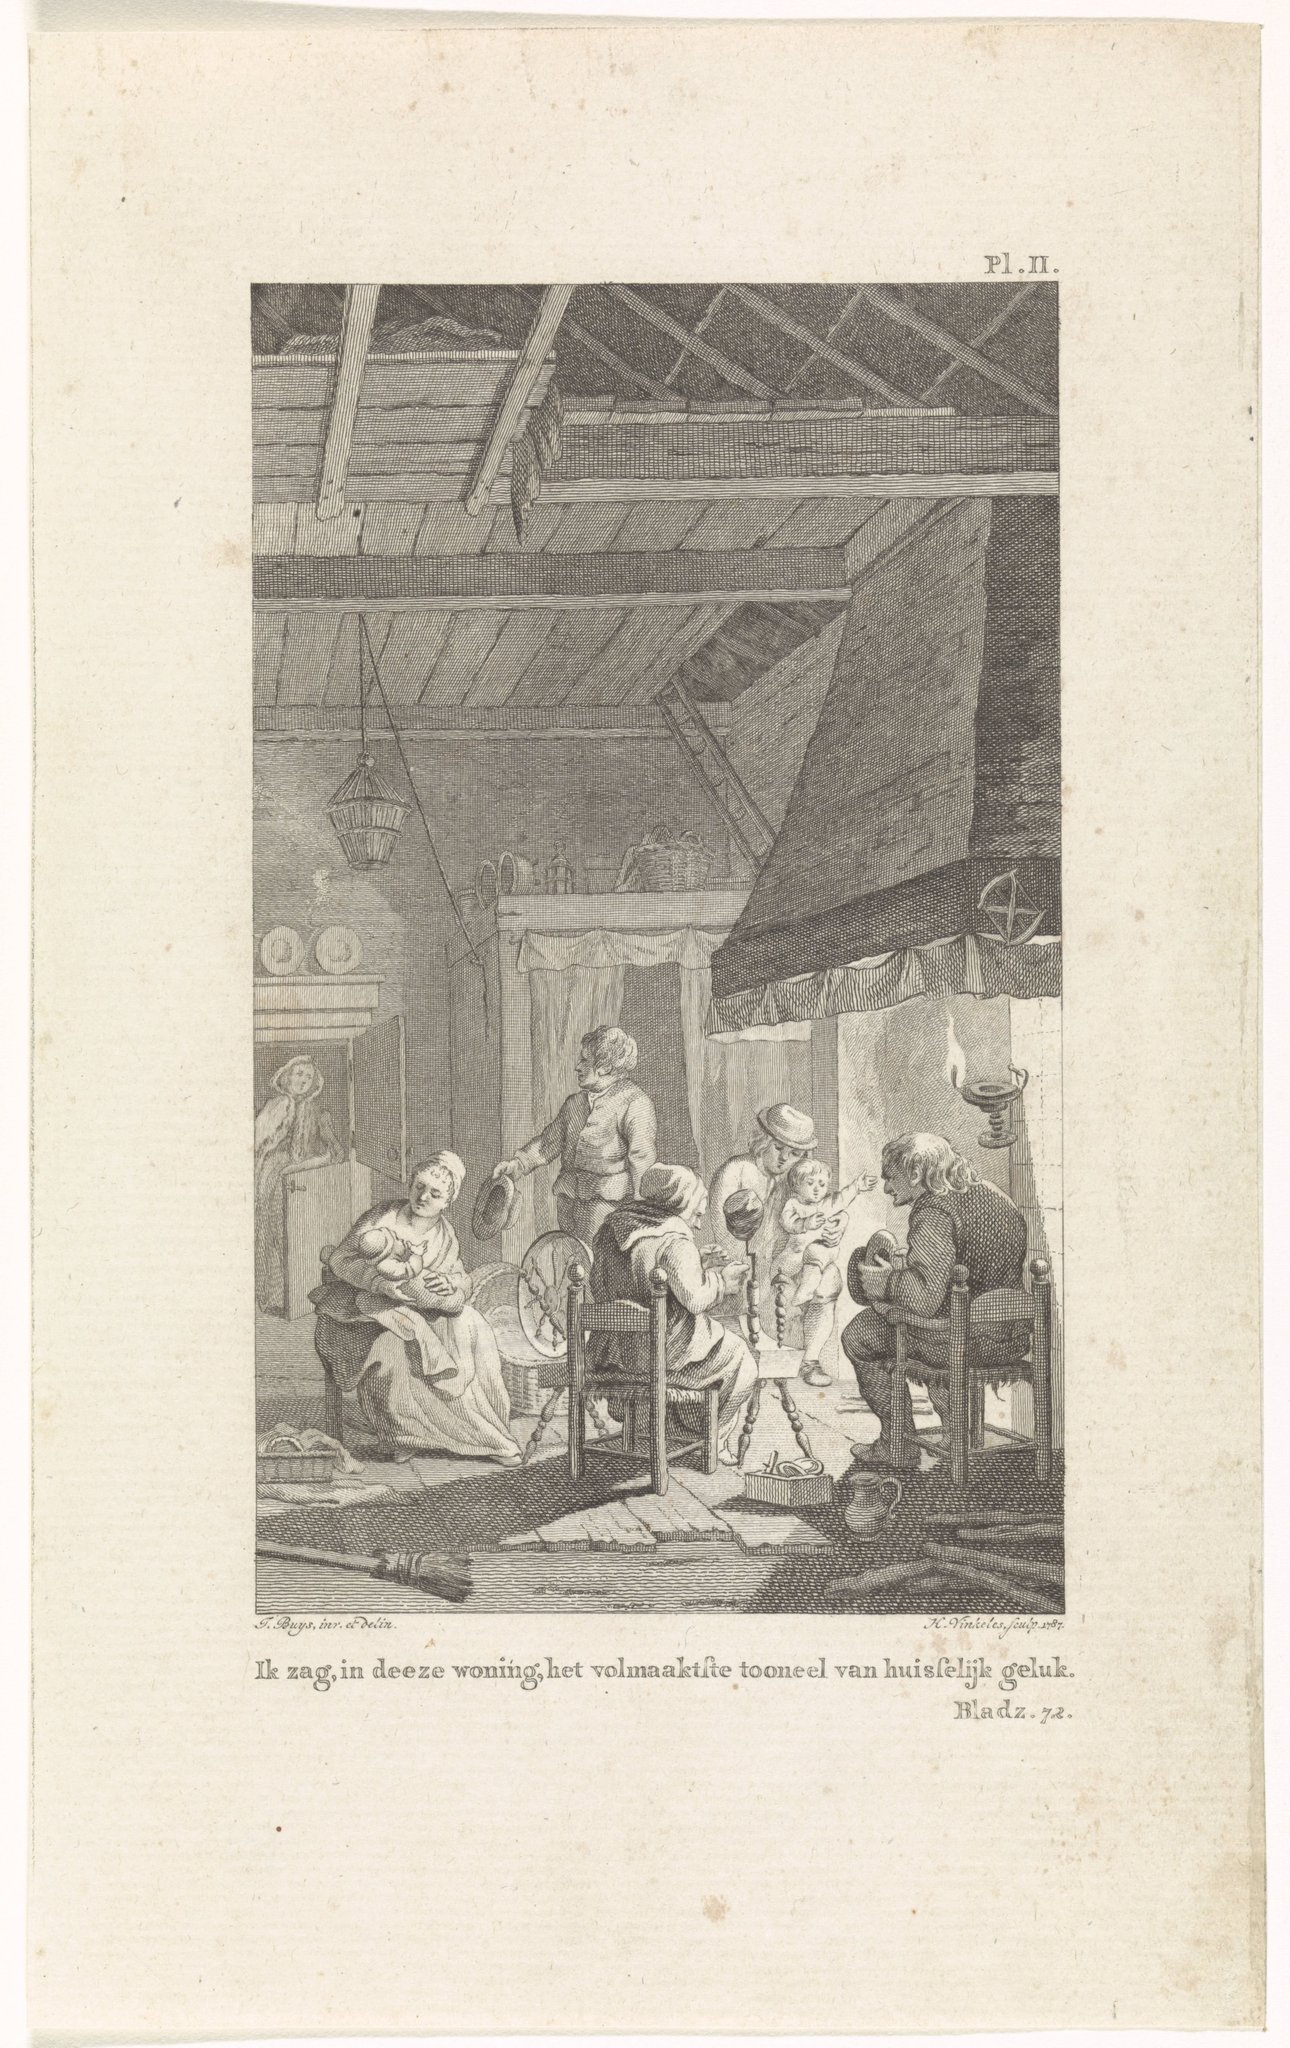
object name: book illustration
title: Boereninterieur met gezin rond een haardvuur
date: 1787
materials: paper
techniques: engraving, etching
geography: amsterdam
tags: open hearth, fire-place, interior of the house, family life at home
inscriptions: collector's mark: Lugt 2760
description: Prent gebruikt als boekillustratie in: Post, Anna Maria. Het land, in brieven. Amsterdam: Johannes Allart, 1788.